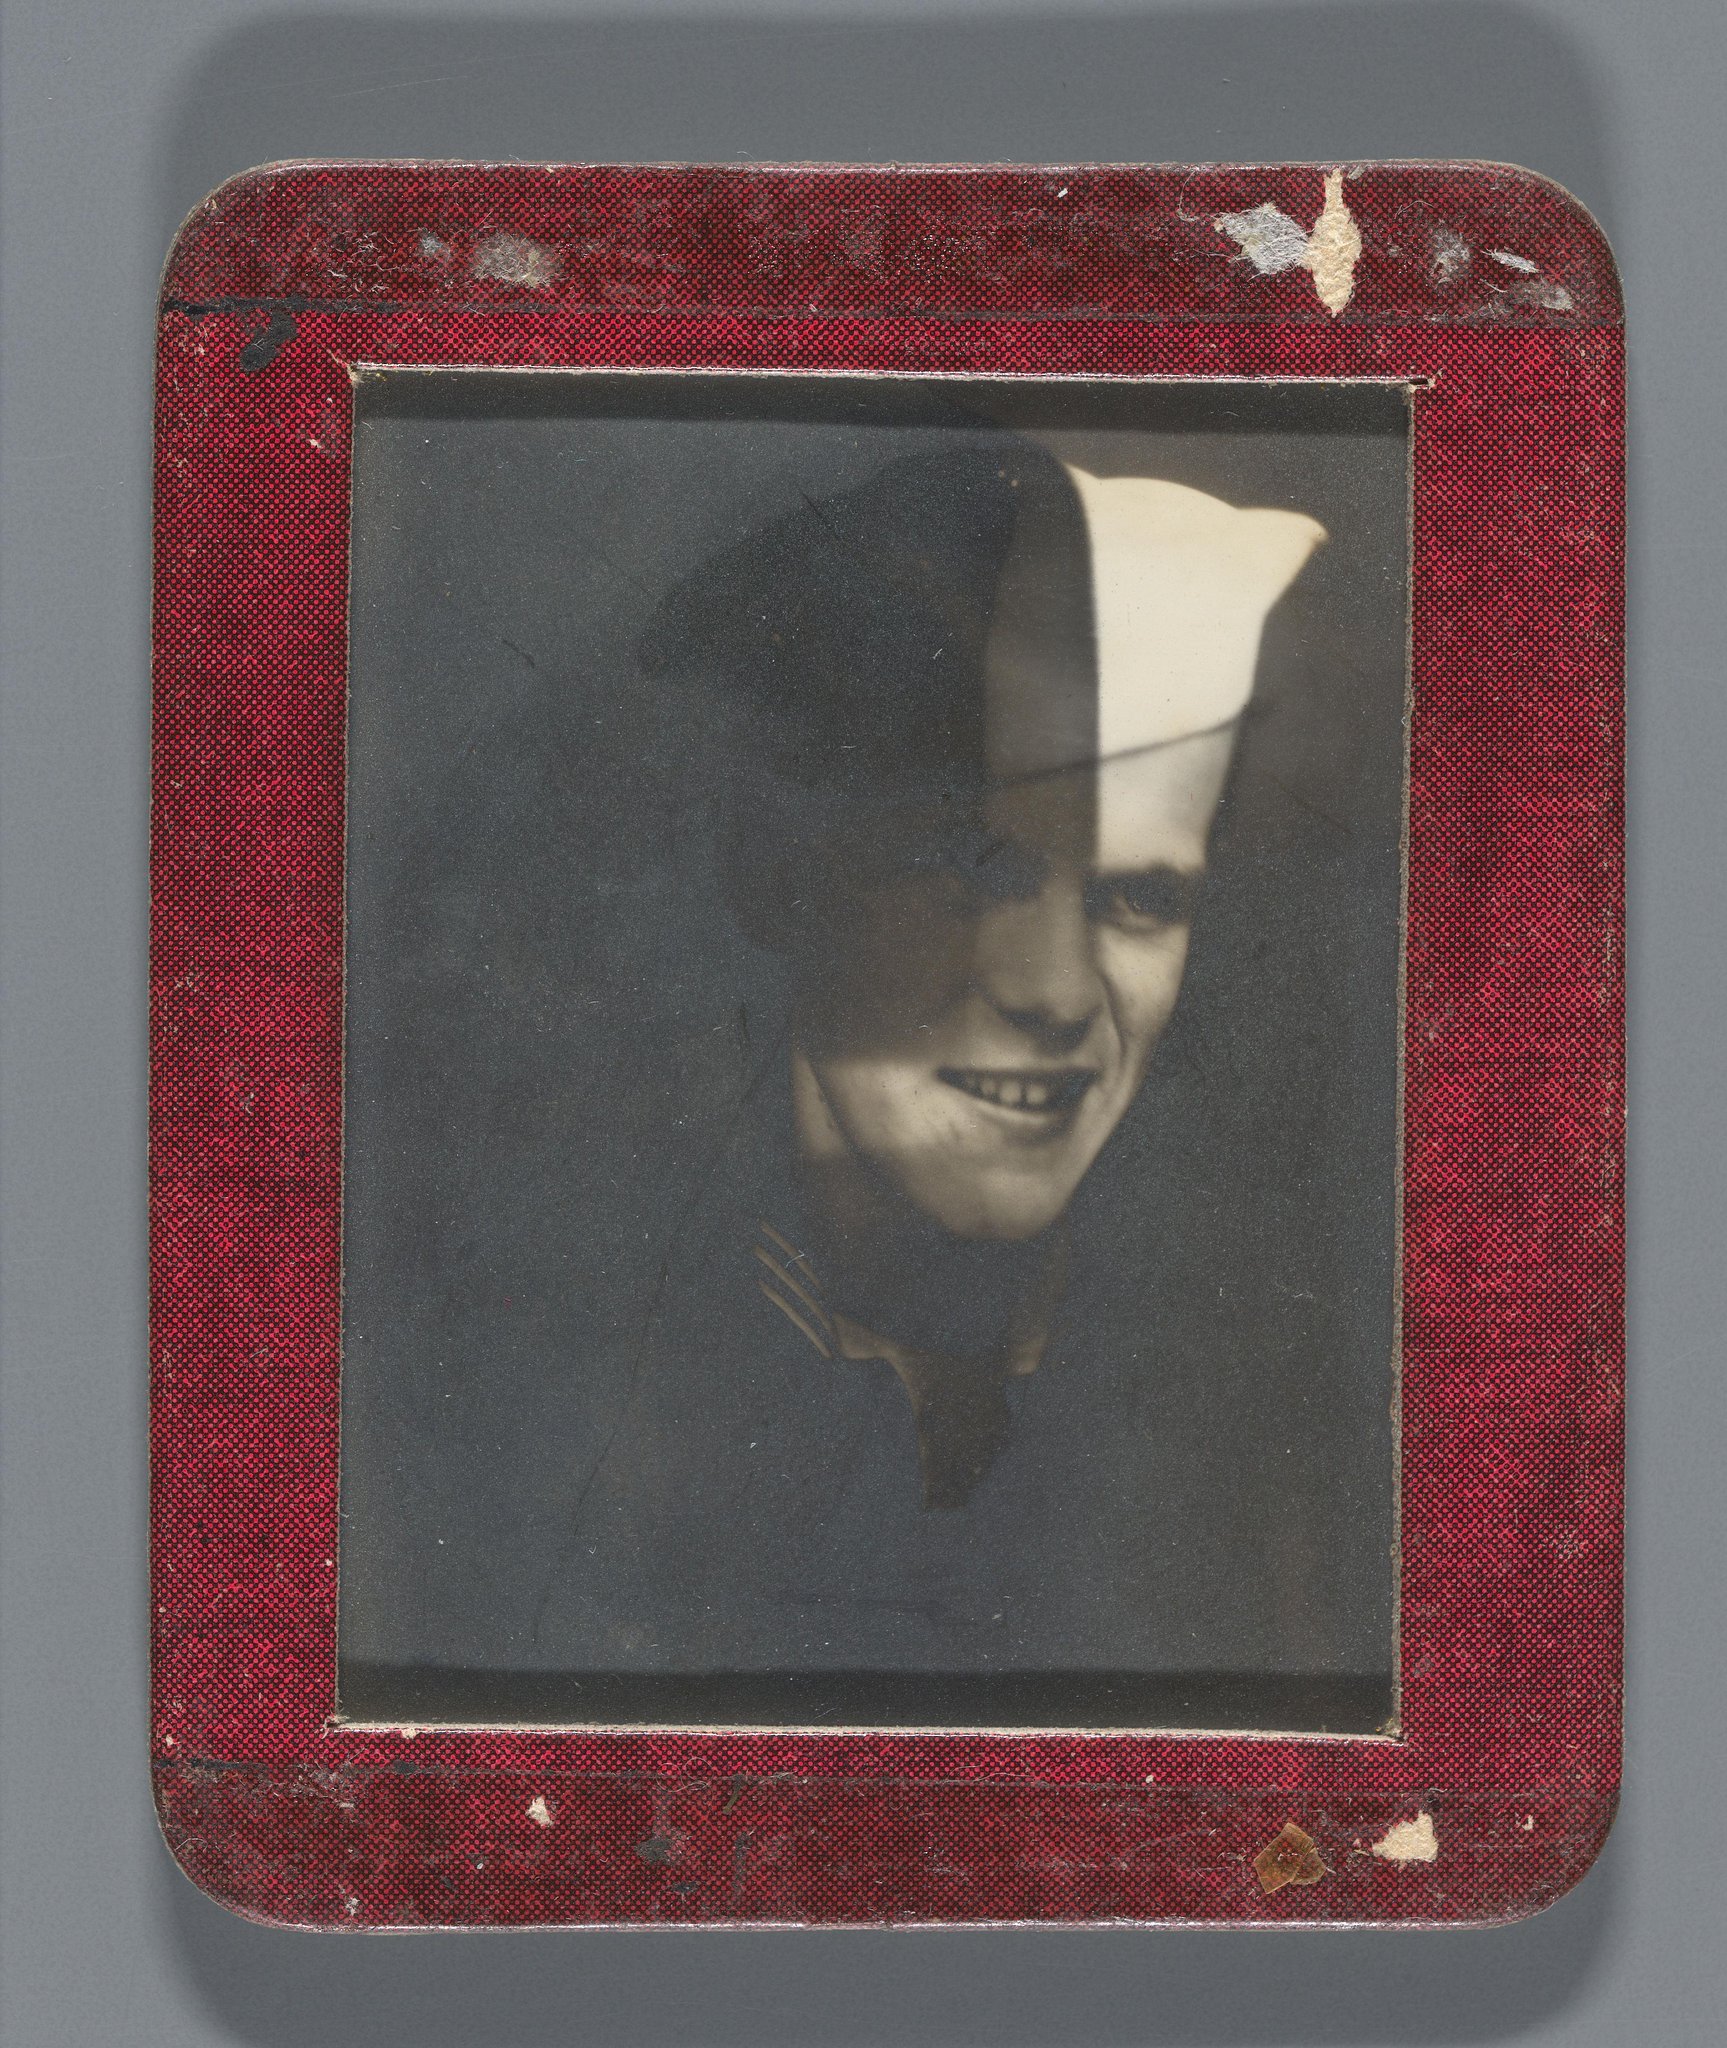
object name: photograph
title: William Swanson, matroos, 1944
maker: Anonymous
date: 1944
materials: photographic support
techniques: gelatin silver print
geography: united states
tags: william swanson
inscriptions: inscription: ‘PHOTOFRAME / T.M. REG U.S. PSAT. OFF. / PATENT PENDING / Taken by the Photomatic / T.M. REG. U.S. PSAT. OFF. / SEE PATENTS LISTED ON / OUR DAYLIGHT LOADING MAGAZINE / MADE IN U.S.A. / INTERNATIONAL MUTOSCOPE / CORPORATION / NEW YORK CITY’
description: Photomatic, portret met hoofddeksel naar rechts.